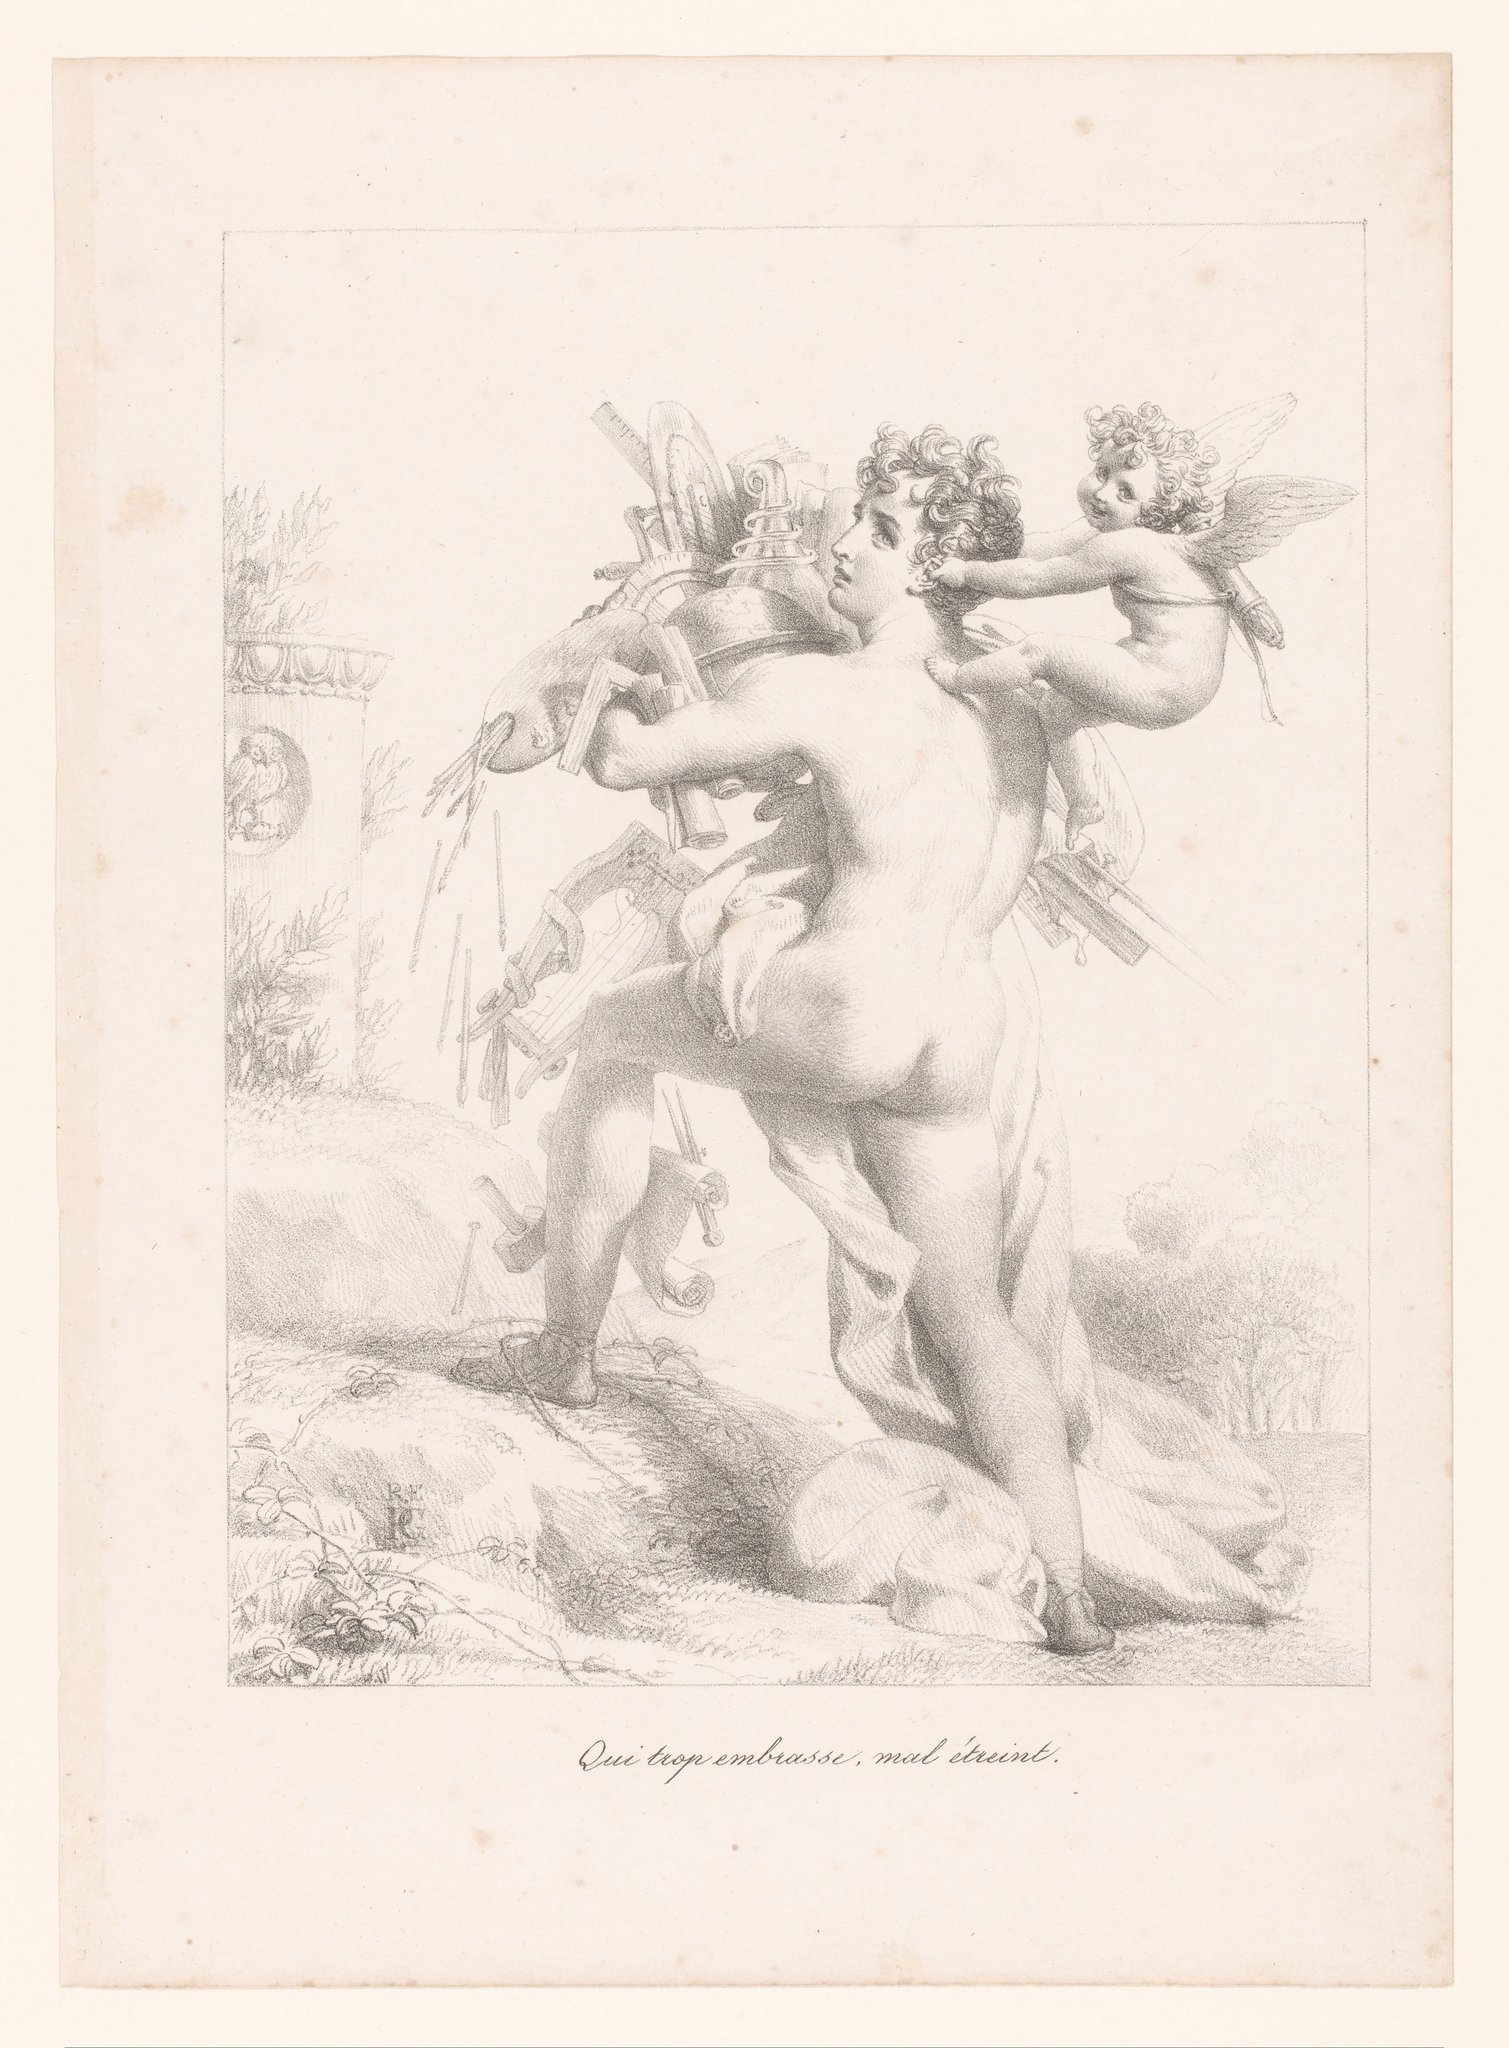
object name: print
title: Overijverige kunstenaar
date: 1816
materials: paper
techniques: lithograph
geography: paris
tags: lyre, cithara, psaltery, alertness, vigilance; 'guardia', 'vigilanza', 'vigilanza per difendersi & oppugnare altri' (ripa) (+ strife between concepts), artist (in general) (+ materials ~ arts), tools, implements of painter, the liberal arts represented otherwise, e.g. by emblems, symbols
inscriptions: collector's mark: Lugt 2760, collector's mark: Lugt 2228a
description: Naakte kunstenaar bestijgt een heuvel met daarop een aan Minerva gewijd altaar. In zijn armen torst hij grote hoeveelheid attributen van kunsten en wetenschappen, waarvan een aantal uit zijn handen valt, waaronder een lier, penselen, een hamer en een passer. Een putto zit op zijn schouder en trekt lachend aan zijn oren. Onderdeel van een groep met verbeeldingen van de luie en de ijverige kunstenaar.